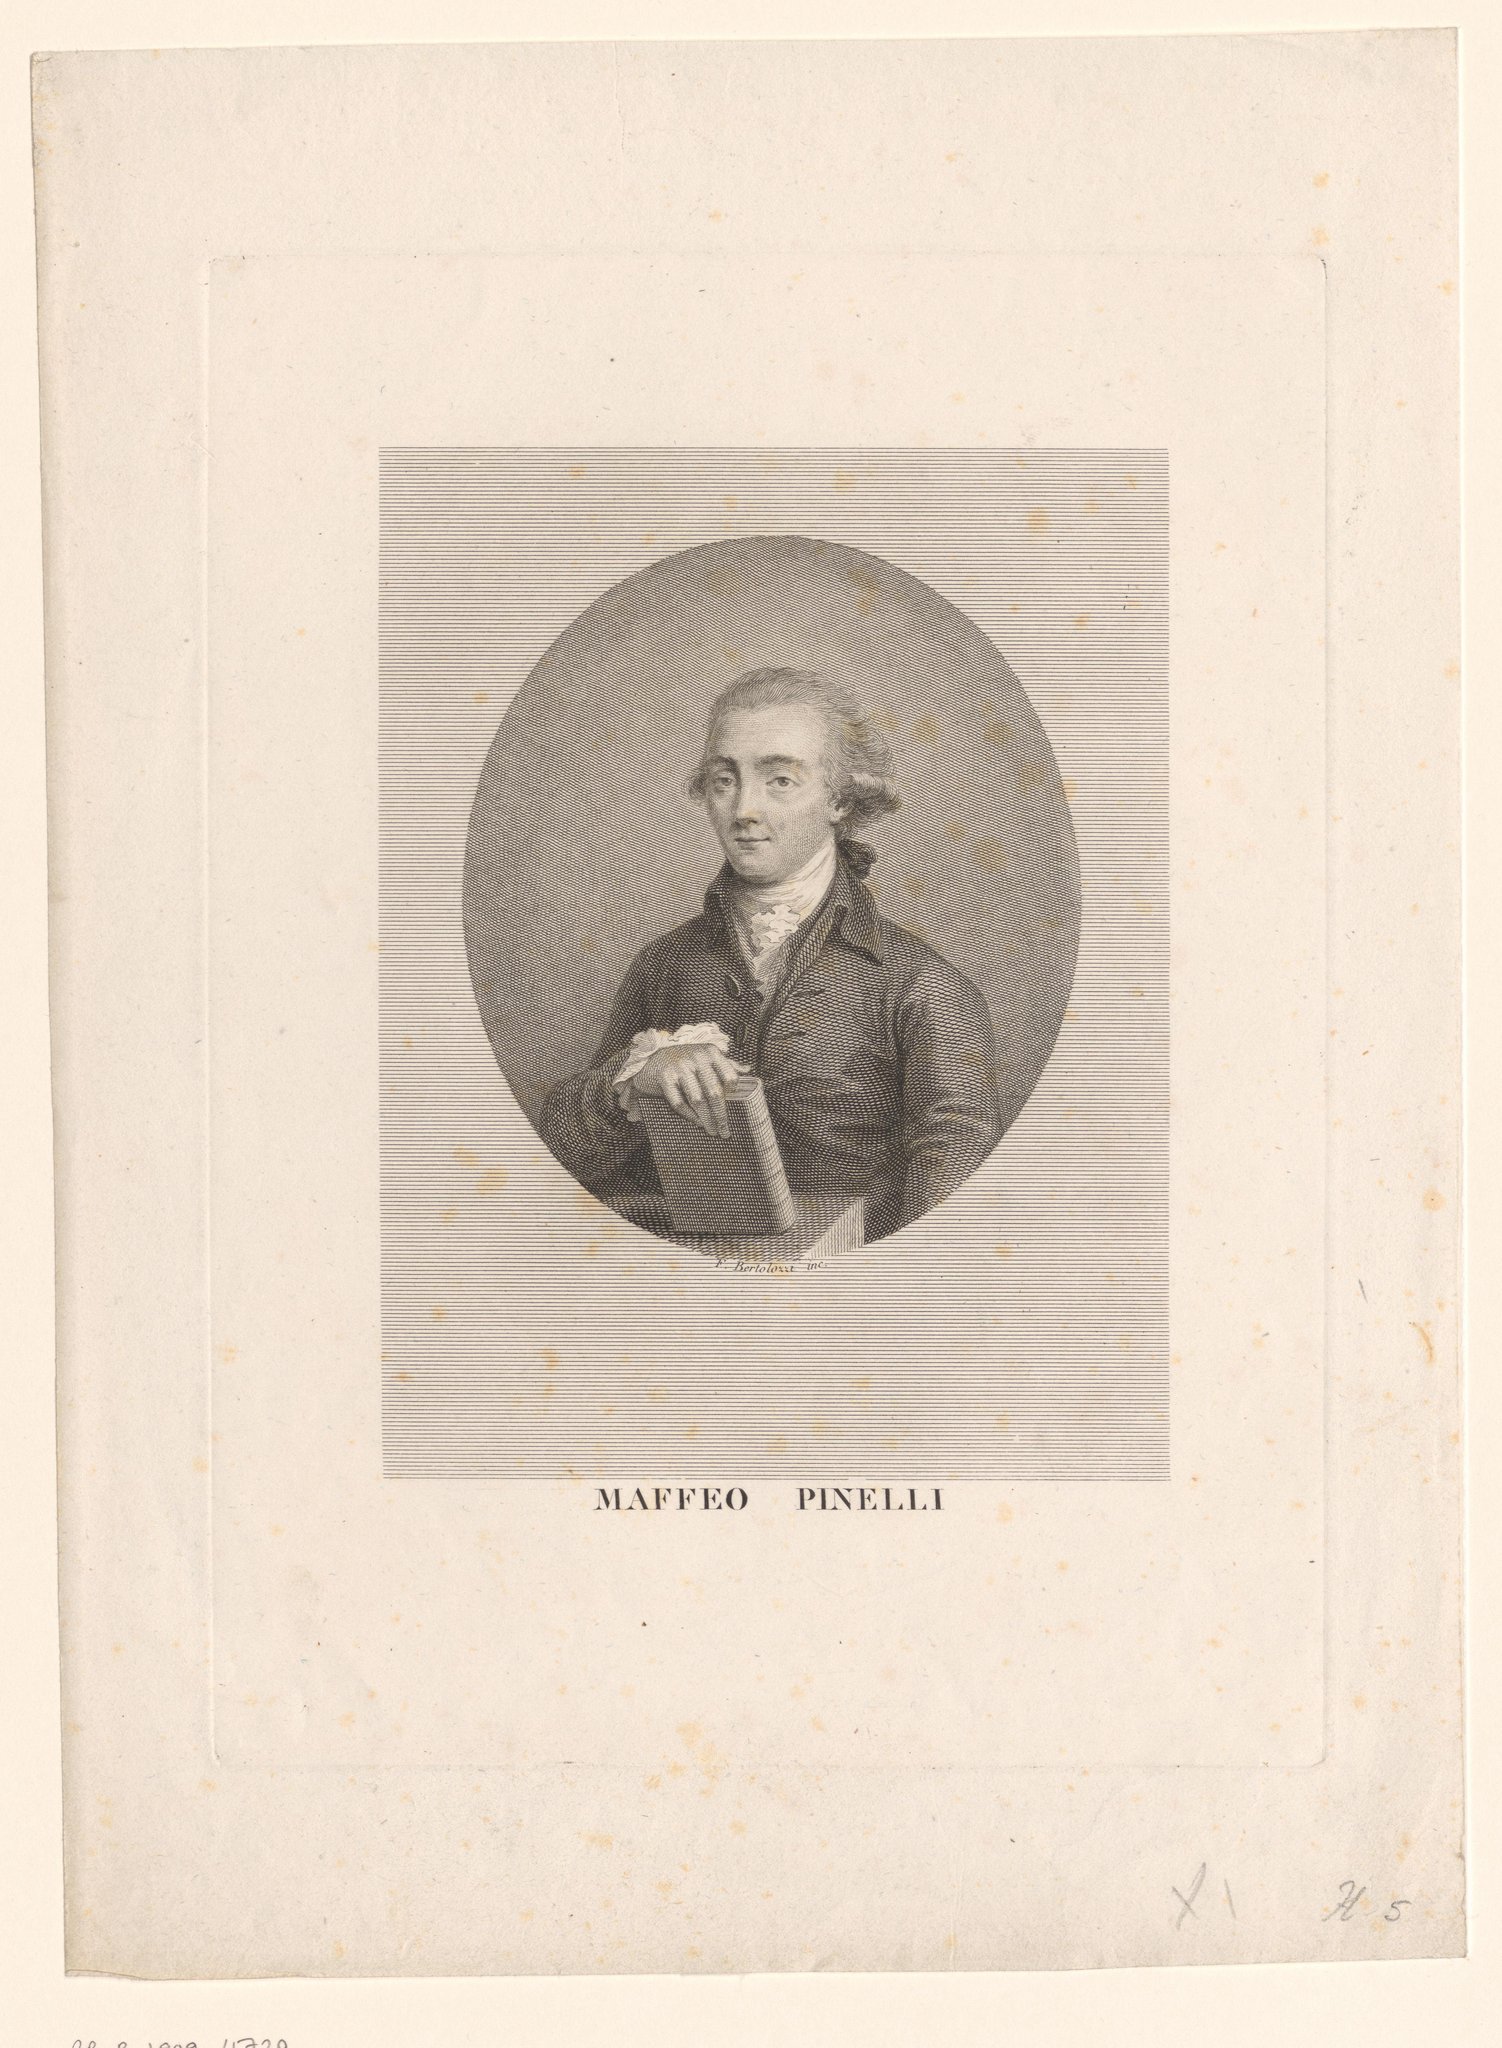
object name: print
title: Portret van Maffeo Pinelli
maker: francesco bartolozzi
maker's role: draughtsman, print maker, publisher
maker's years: 1727-1815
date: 1755-1815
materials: paper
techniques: engraving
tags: venice, printer, adult man, historical persons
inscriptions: collector's mark: Lugt 2228